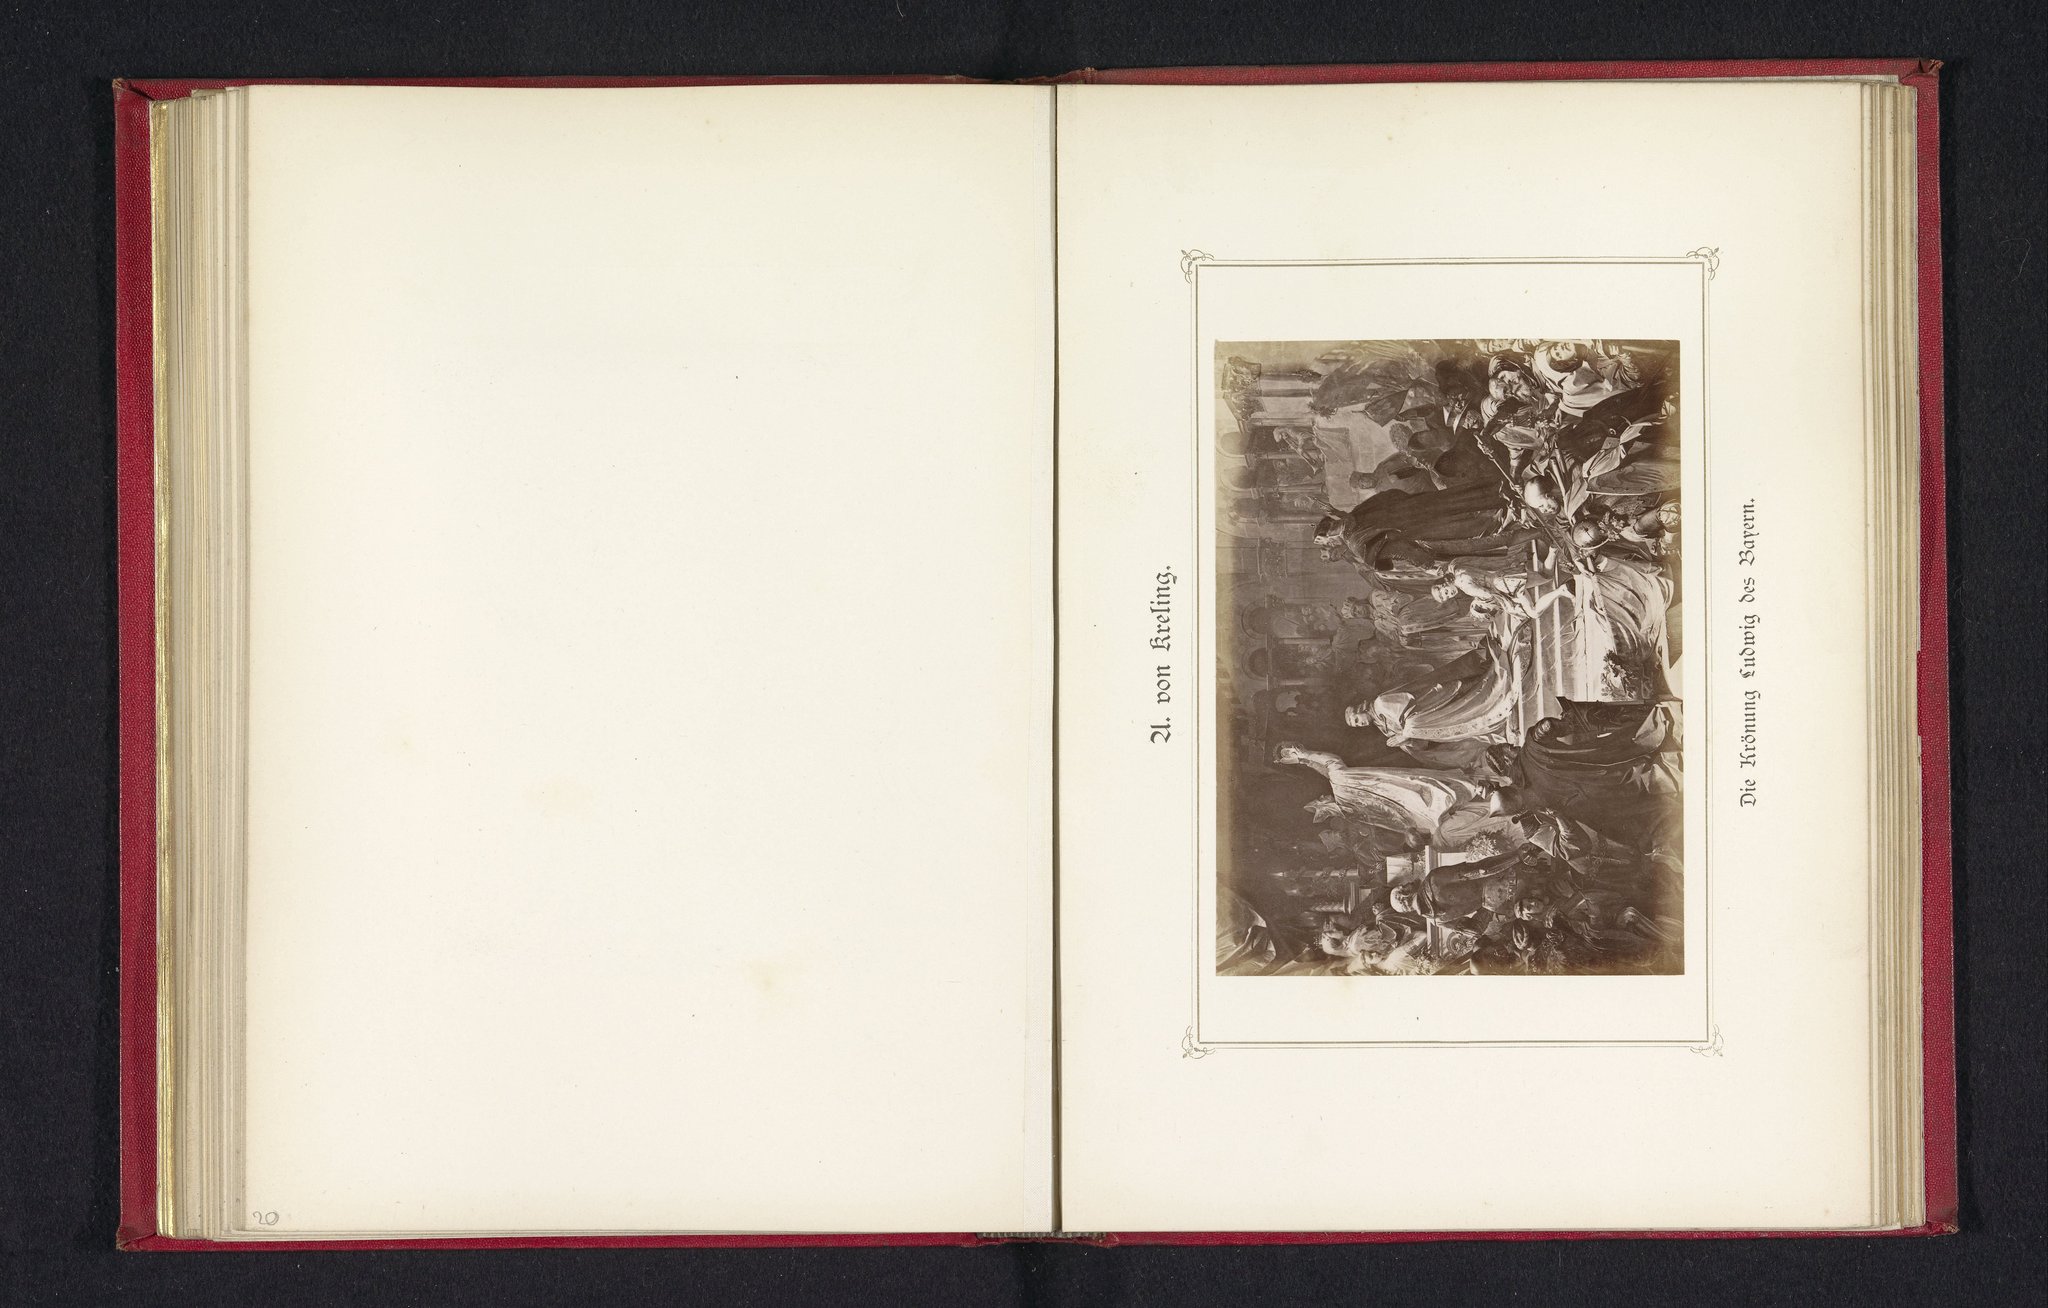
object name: page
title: Fotoreproductie van een schilderij, voorstellende de kroning van keizer Lodewijk de Beier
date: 1875-1880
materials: photographic support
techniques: albumen print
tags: coronation of a ruler, emperor